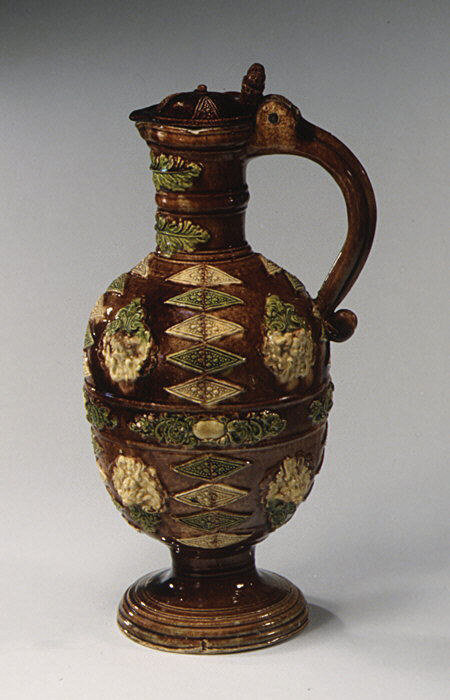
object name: jug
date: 1601-1700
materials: faience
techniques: glazing